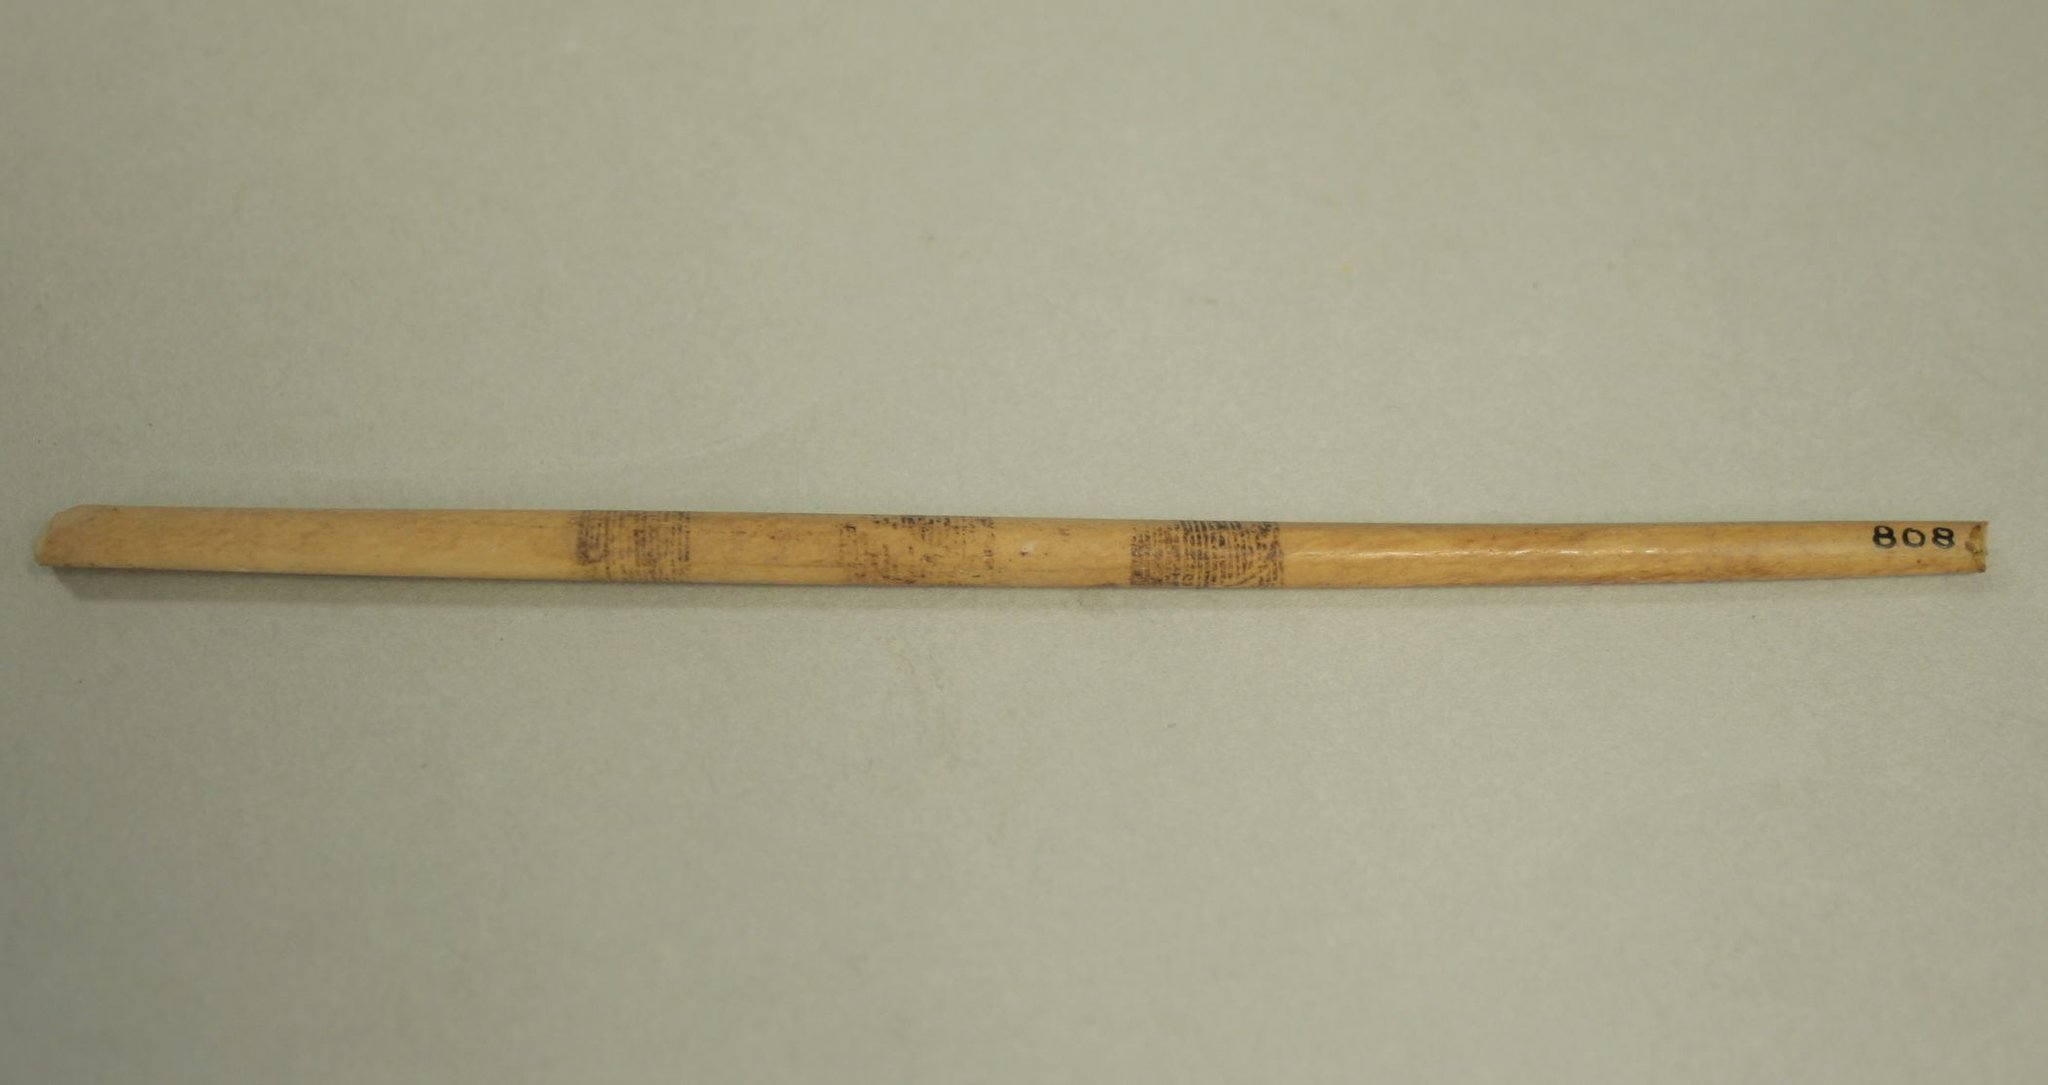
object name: bobbin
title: Bone Weaving Bobbin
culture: peruvian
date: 701-1566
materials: bone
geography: peru